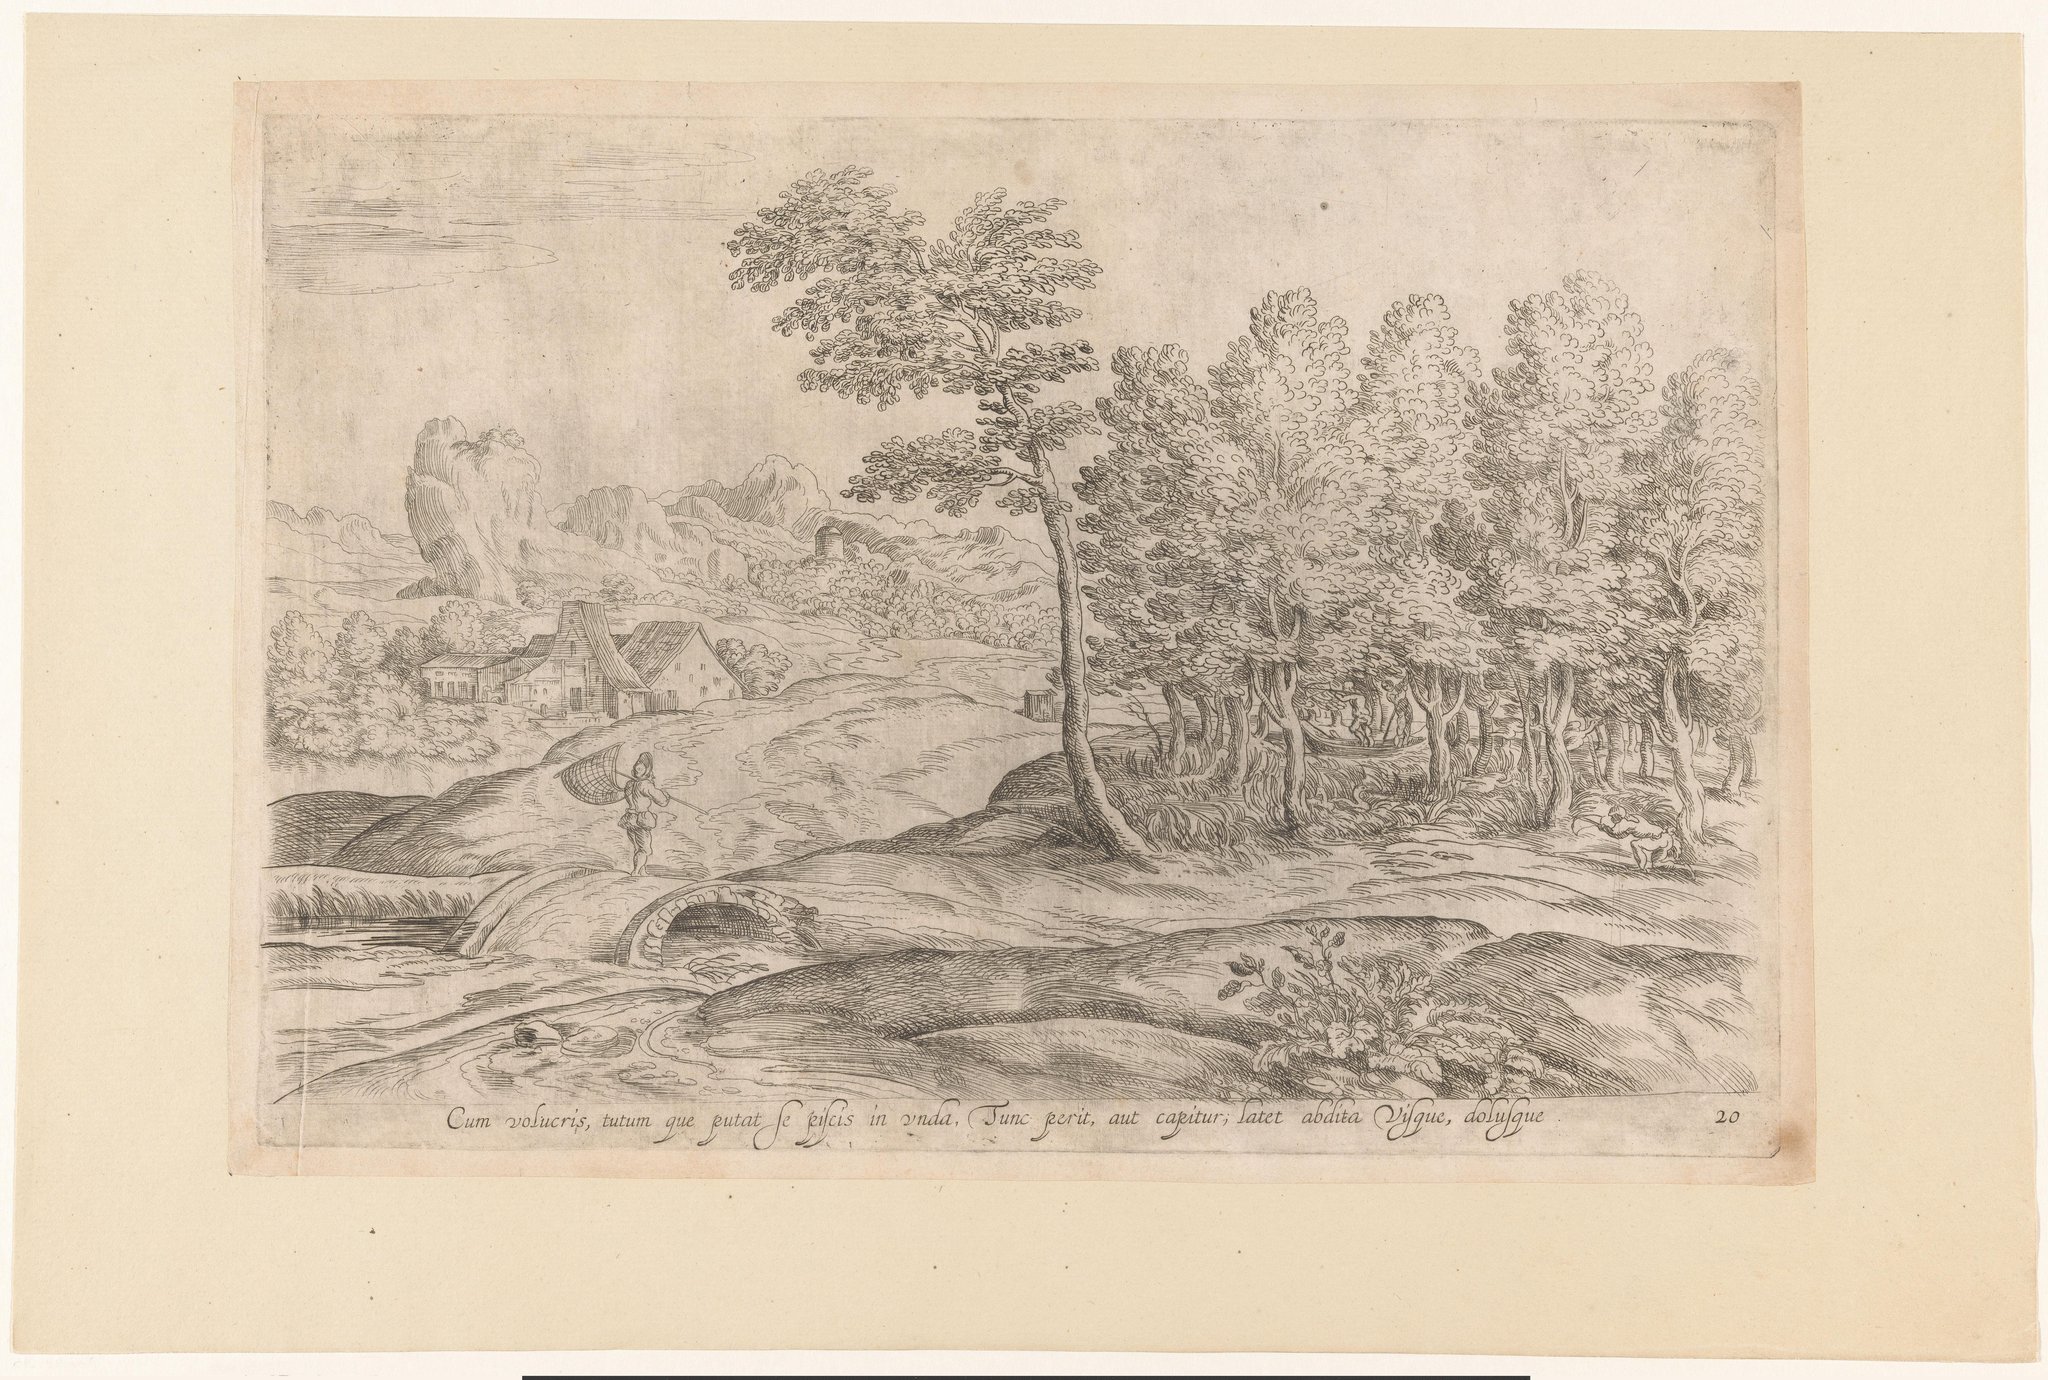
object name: print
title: Cum volucris, tutum que putat se piscis in unda, tunc perit, aut capitur; latet abdita Visque, dolusque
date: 1600-1699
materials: paper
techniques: etching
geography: italy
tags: landscapes, fishing net, fisherman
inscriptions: collector's mark: Lugt 2228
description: Landschap met op de voorgrond links een brug over een stroom en een visser met een net. Rechts tussen de bomen jagers die op watervogels jagen. Titel in het Latijn in ondermarge. Genummerd rechtsonder: 20.